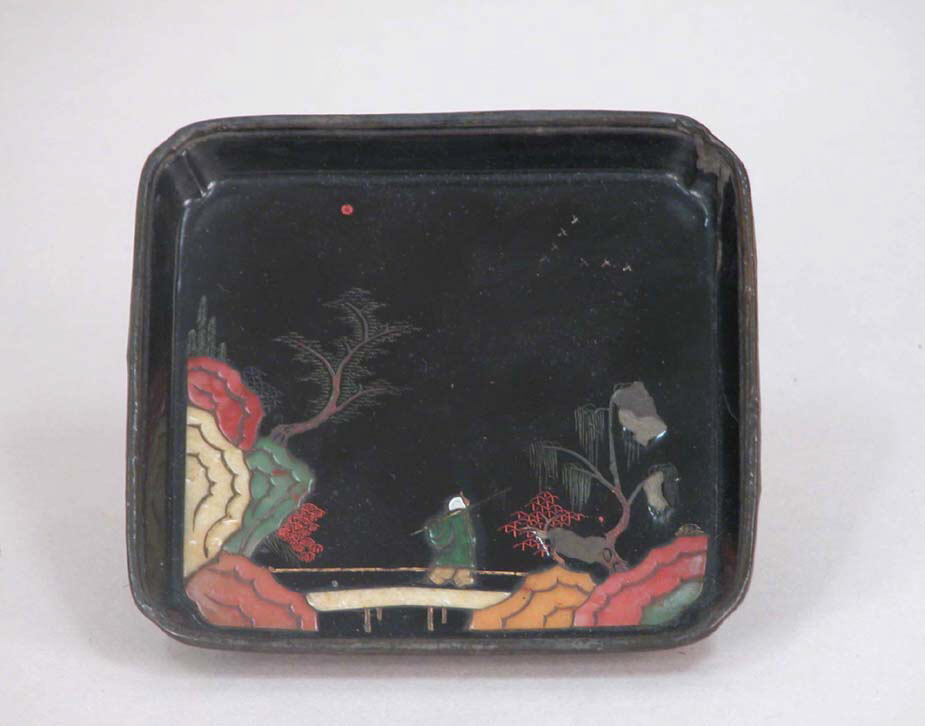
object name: tray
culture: chinese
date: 1601-1700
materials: lacquer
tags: human figures,trees